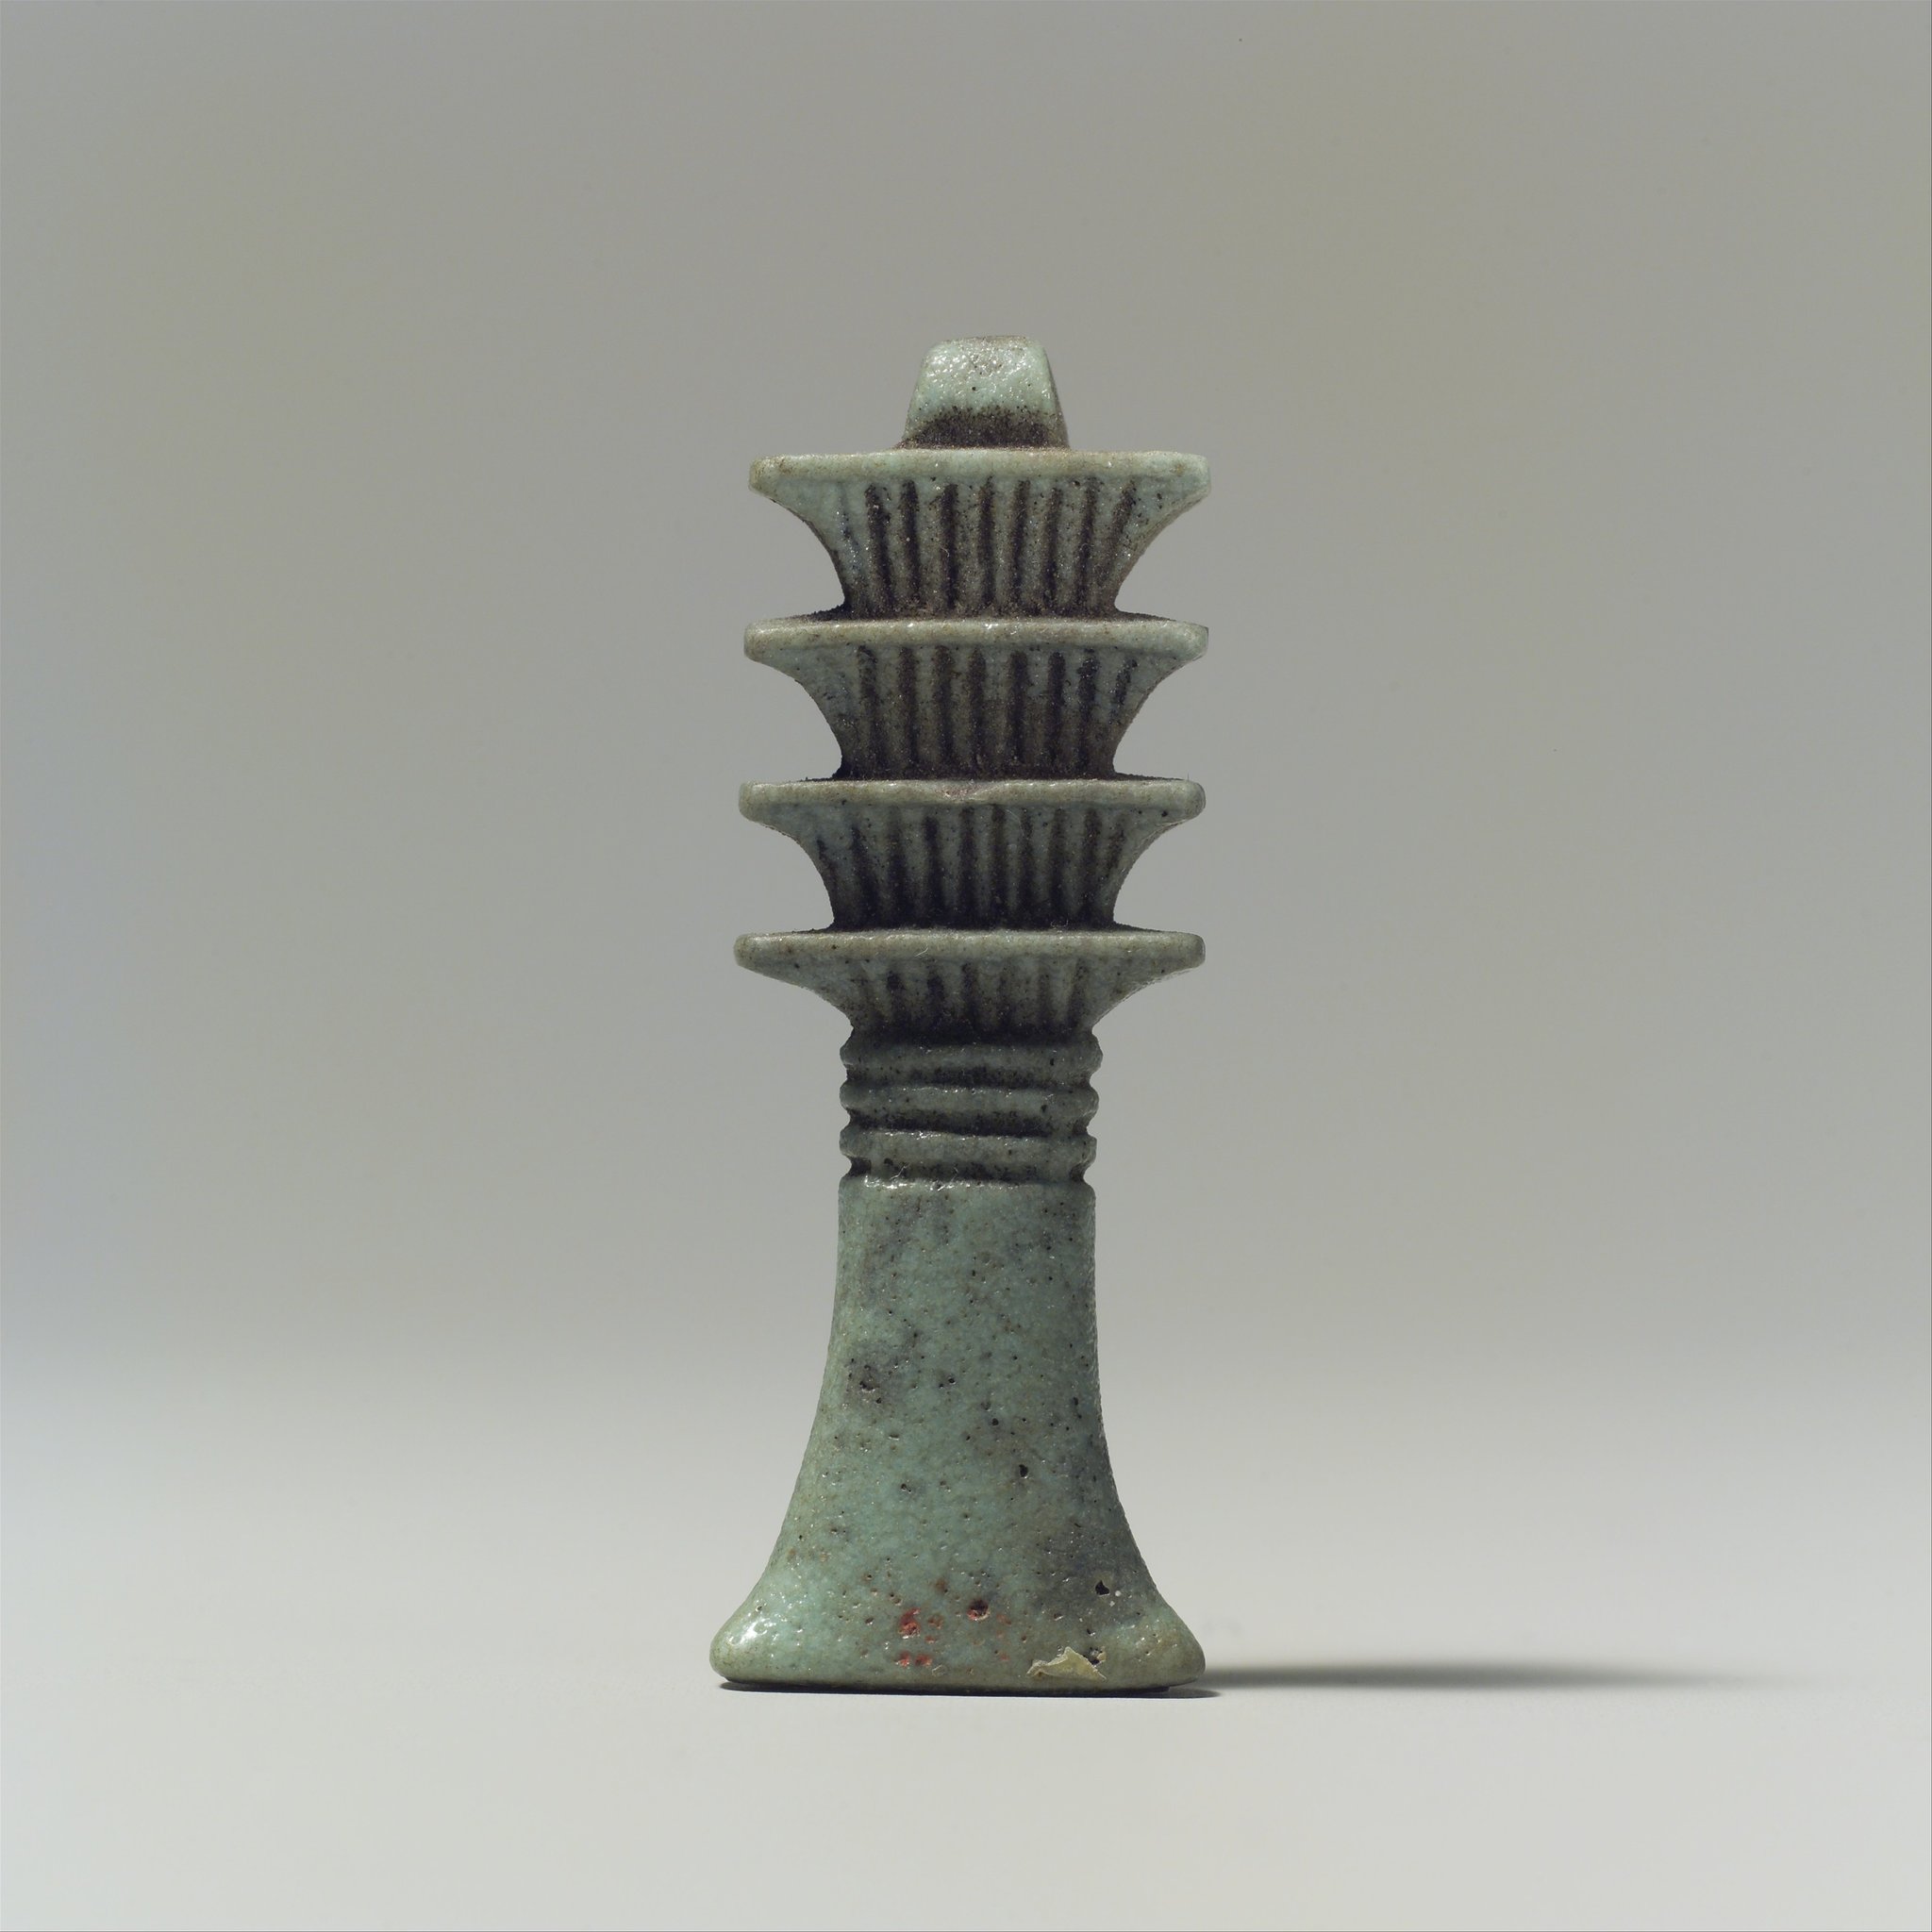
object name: amulet, djed pillar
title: Djed Pillar Amulet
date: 1086 BCE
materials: faience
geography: egypt